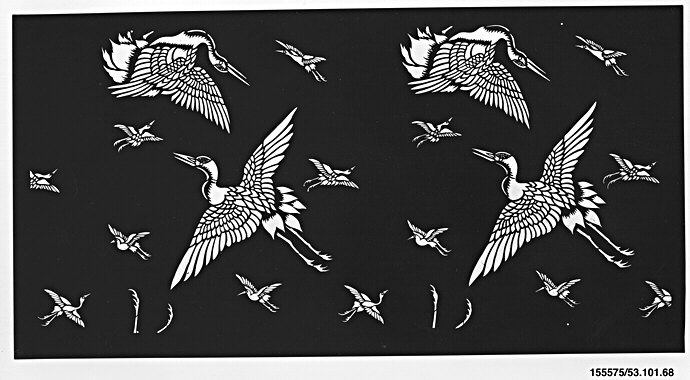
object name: stencil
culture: japanese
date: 1615-1868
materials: paper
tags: cranes